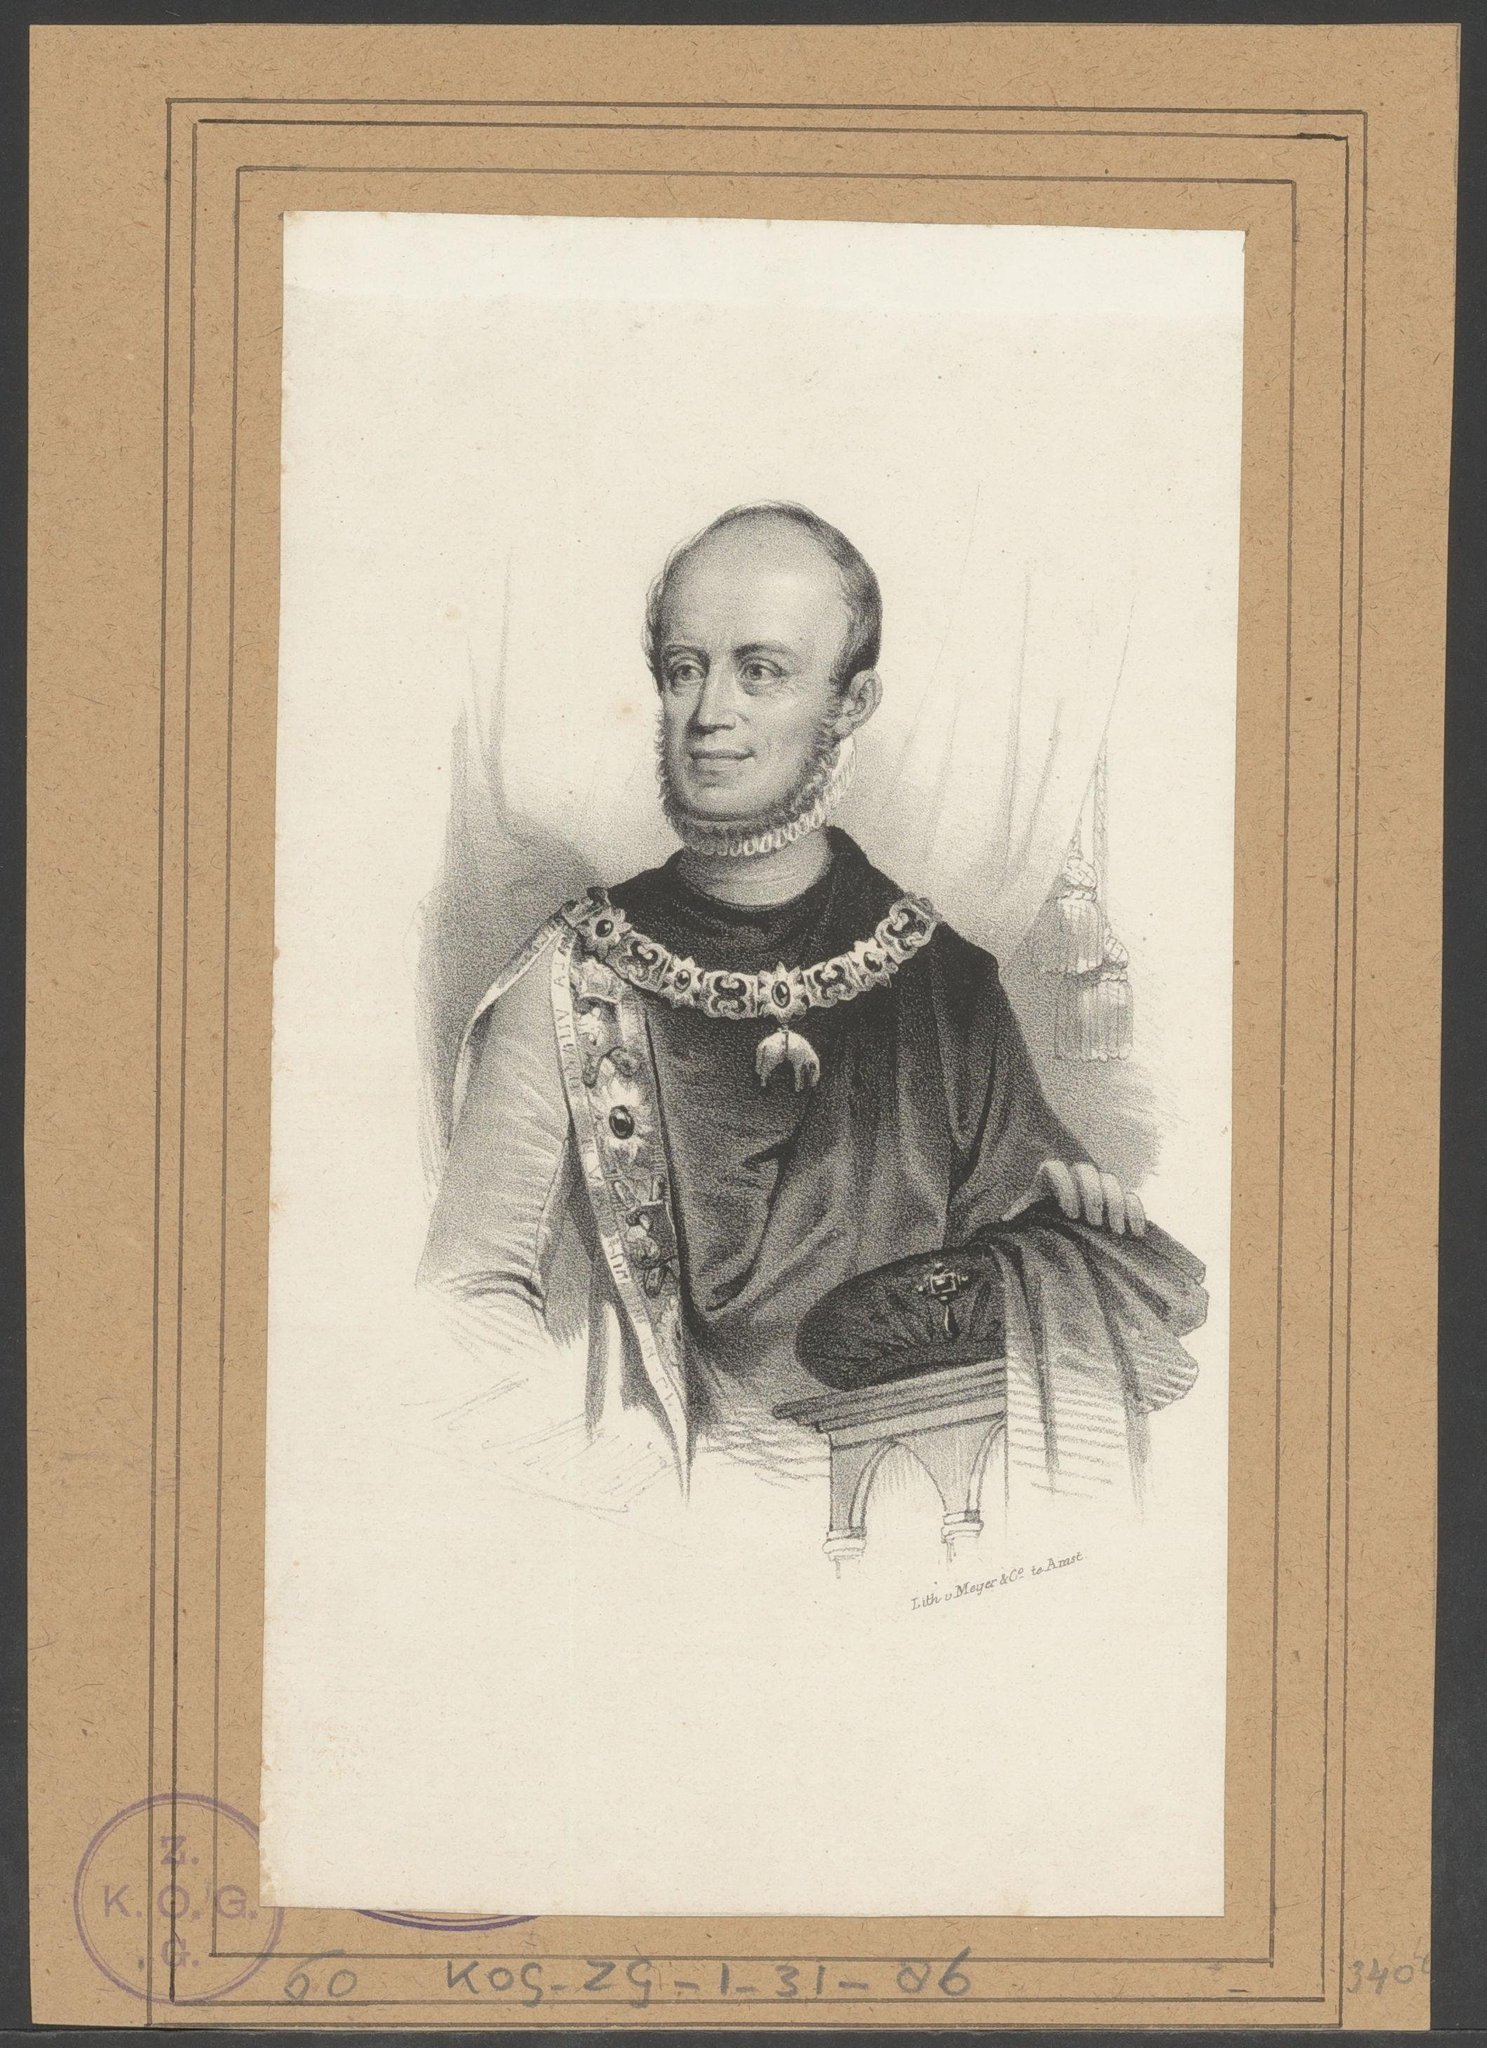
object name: print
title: Portret van Willem II, koning der Nederlanden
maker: michel mourot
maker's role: draughtsman, print maker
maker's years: 1803-1847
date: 1843-1861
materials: paper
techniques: lithograph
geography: amsterdam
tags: the hague, william ii of the netherlands, historical persons, knighthood order of the golden fleece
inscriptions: collector's mark: Lugt 1641, stamp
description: Onderwerpsrubrieken binnen de Atlas Zeden en Gewoonten: Portretten, Portretten van Vorsten uit het huis van Oranje, Regeerende Vorsten, Koningen uit het huis van Oranje.